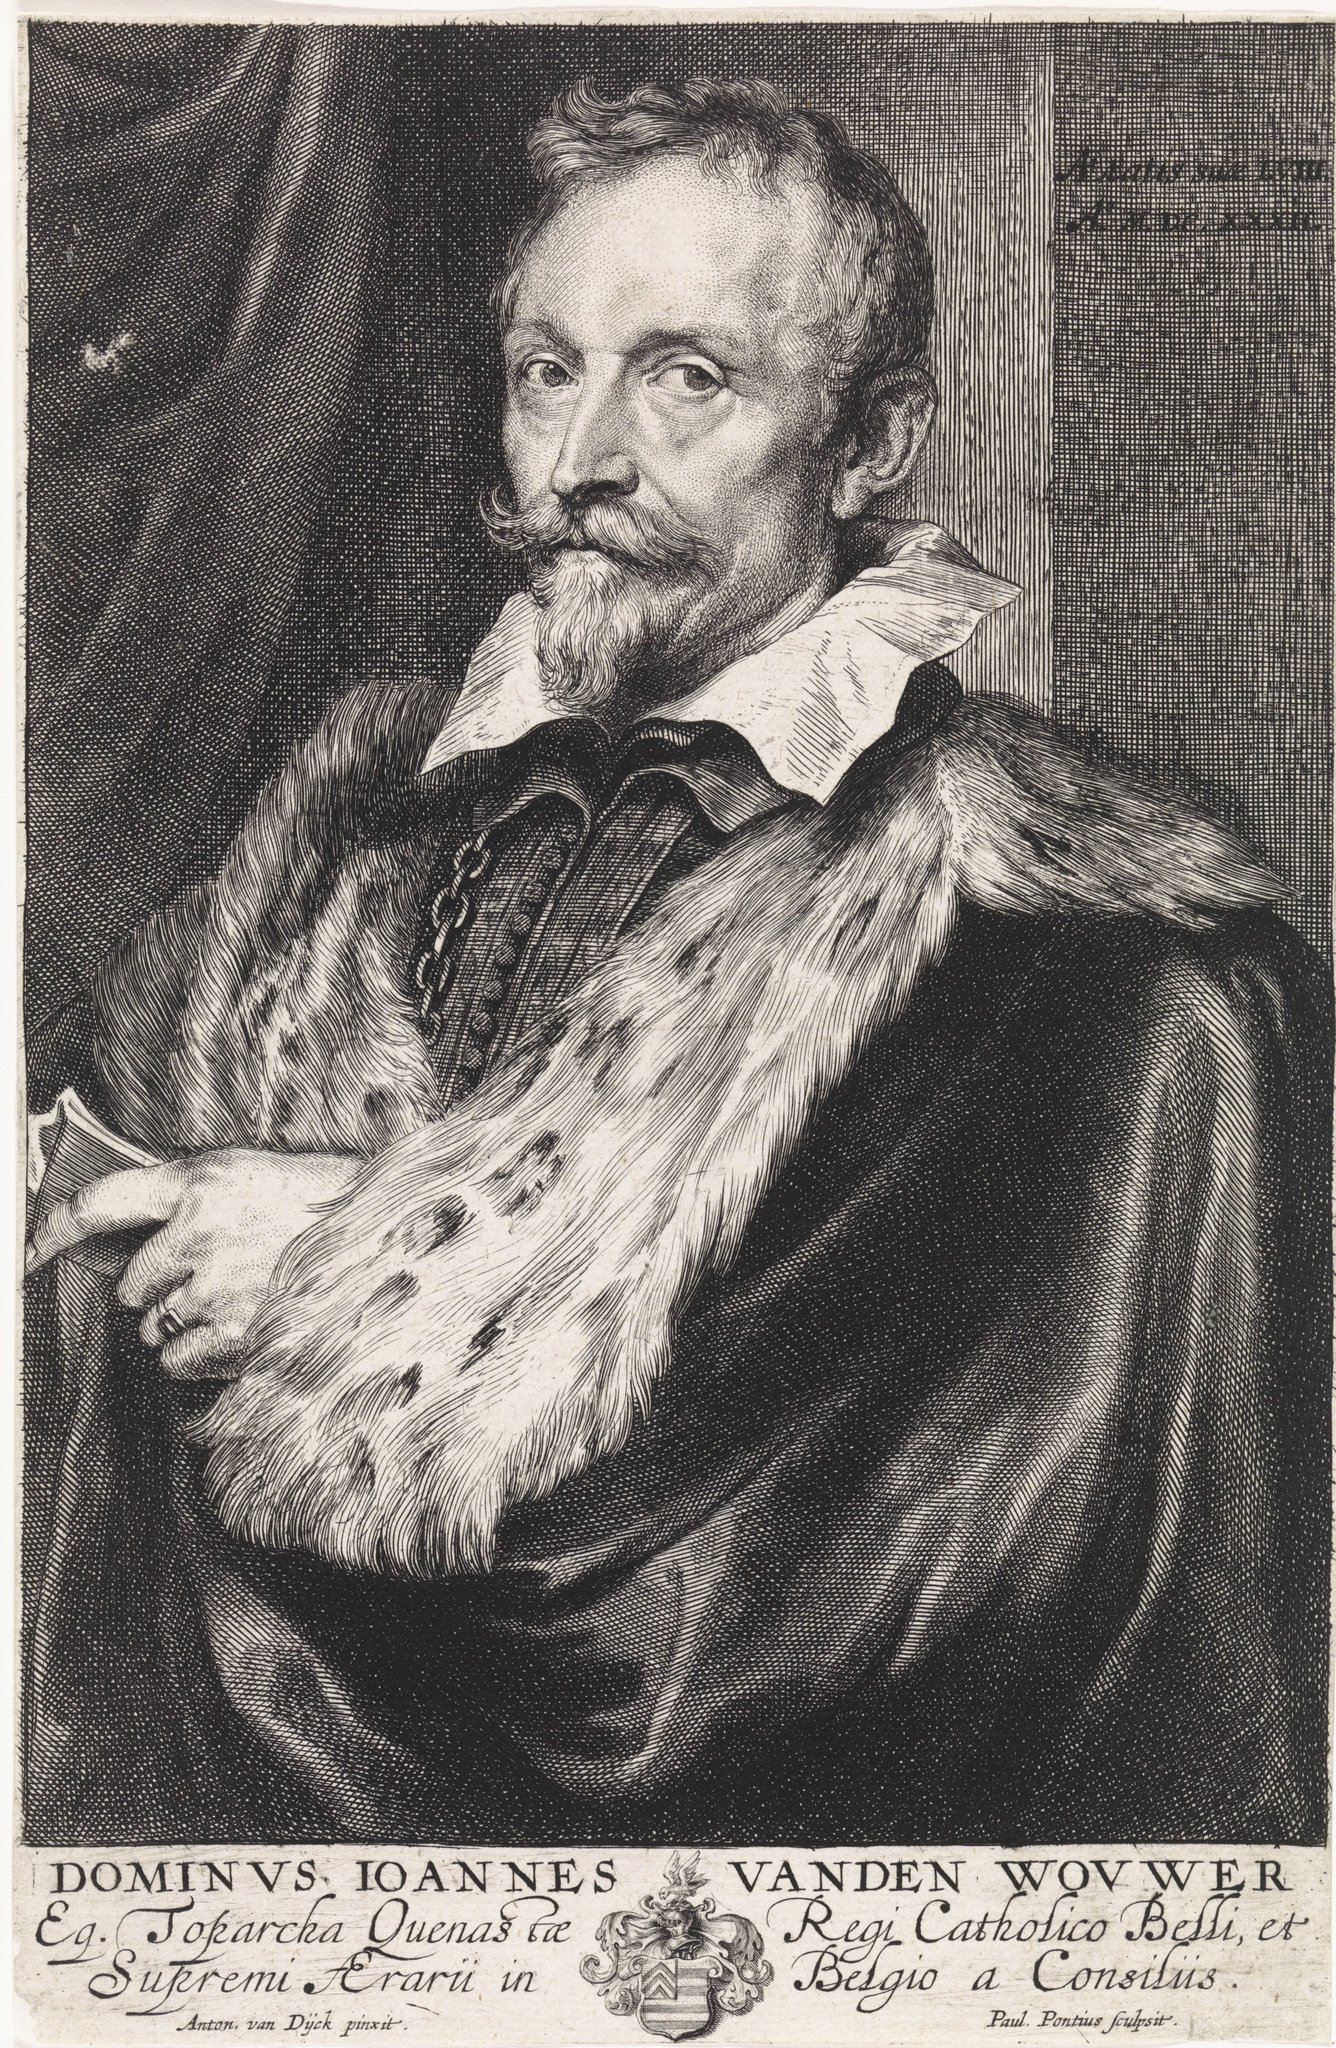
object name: print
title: Portret van Jan van den Wouwer, op 58-jarige leeftijd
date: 1616-1657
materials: paper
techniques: engraving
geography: antwerp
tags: antwerp, brussels, jan van den wouwer, armorial bearing, heraldry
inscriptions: collector's mark: Lugt 240